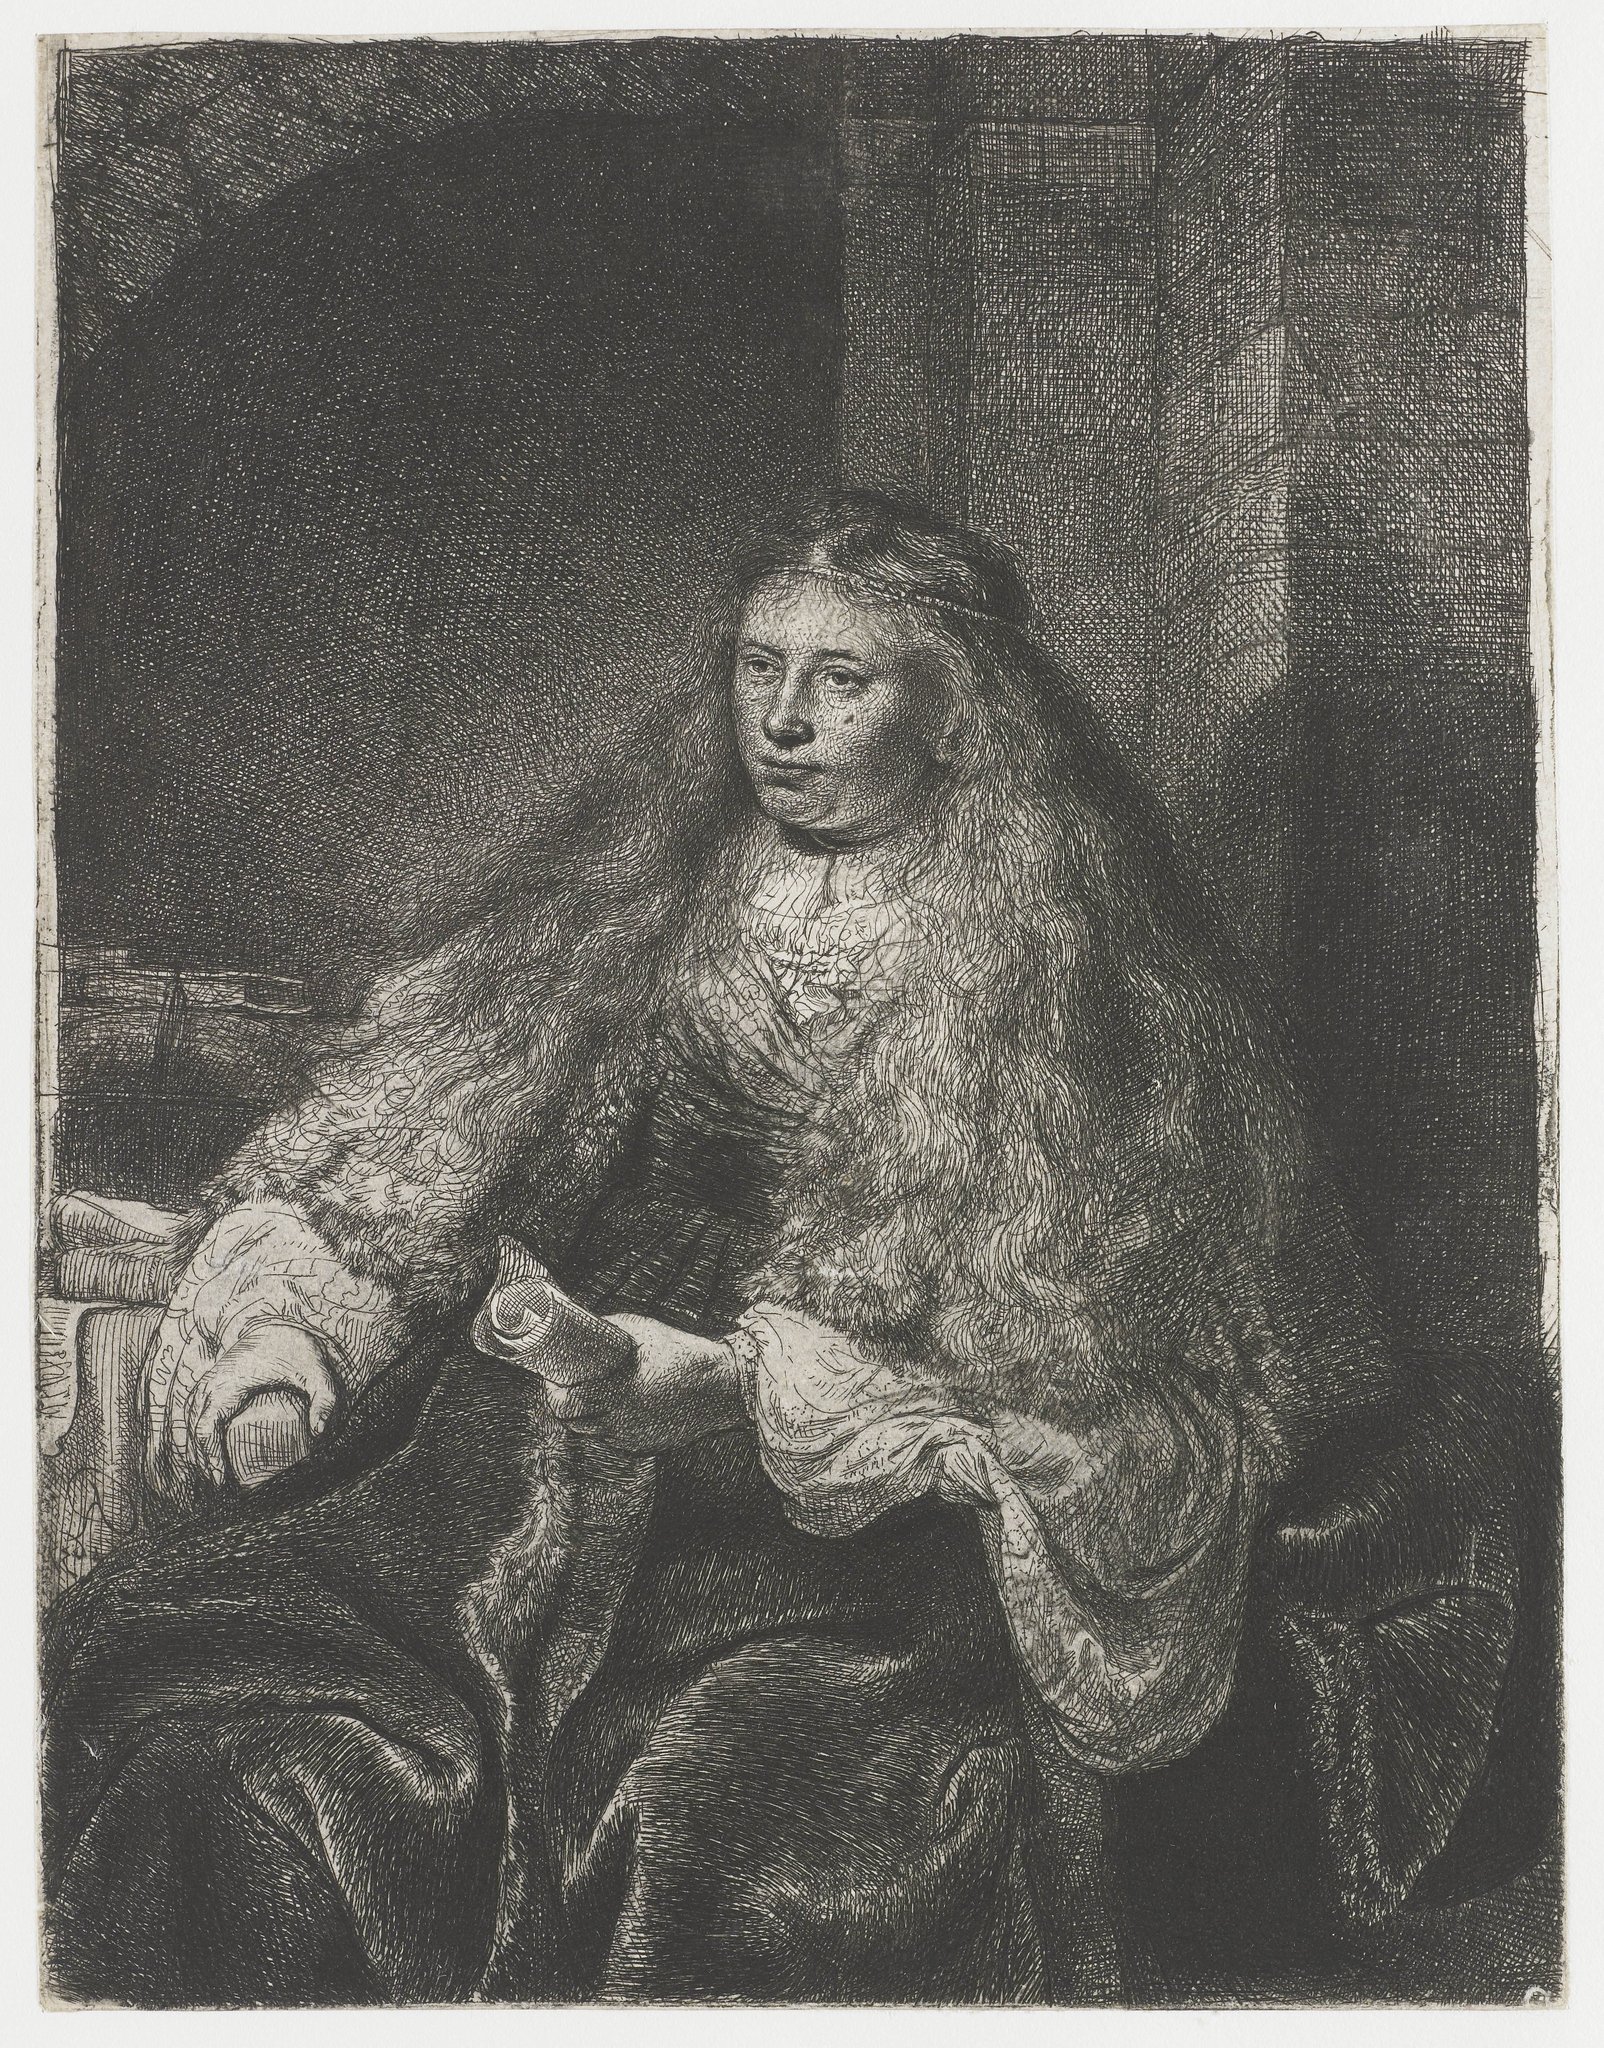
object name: print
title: The great Jewish bride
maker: rembrandt van rijn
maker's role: draughtsman, painter, print maker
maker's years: 1606-1669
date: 1635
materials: chalk, paper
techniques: drypoint, etching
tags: bride (in wedding-dress)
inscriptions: mark: Lugt 2228, inscription: ‘C. 21761’, inscription: ‘Lo Butes Col / No 63’, monogram and date: ‘R 1635’